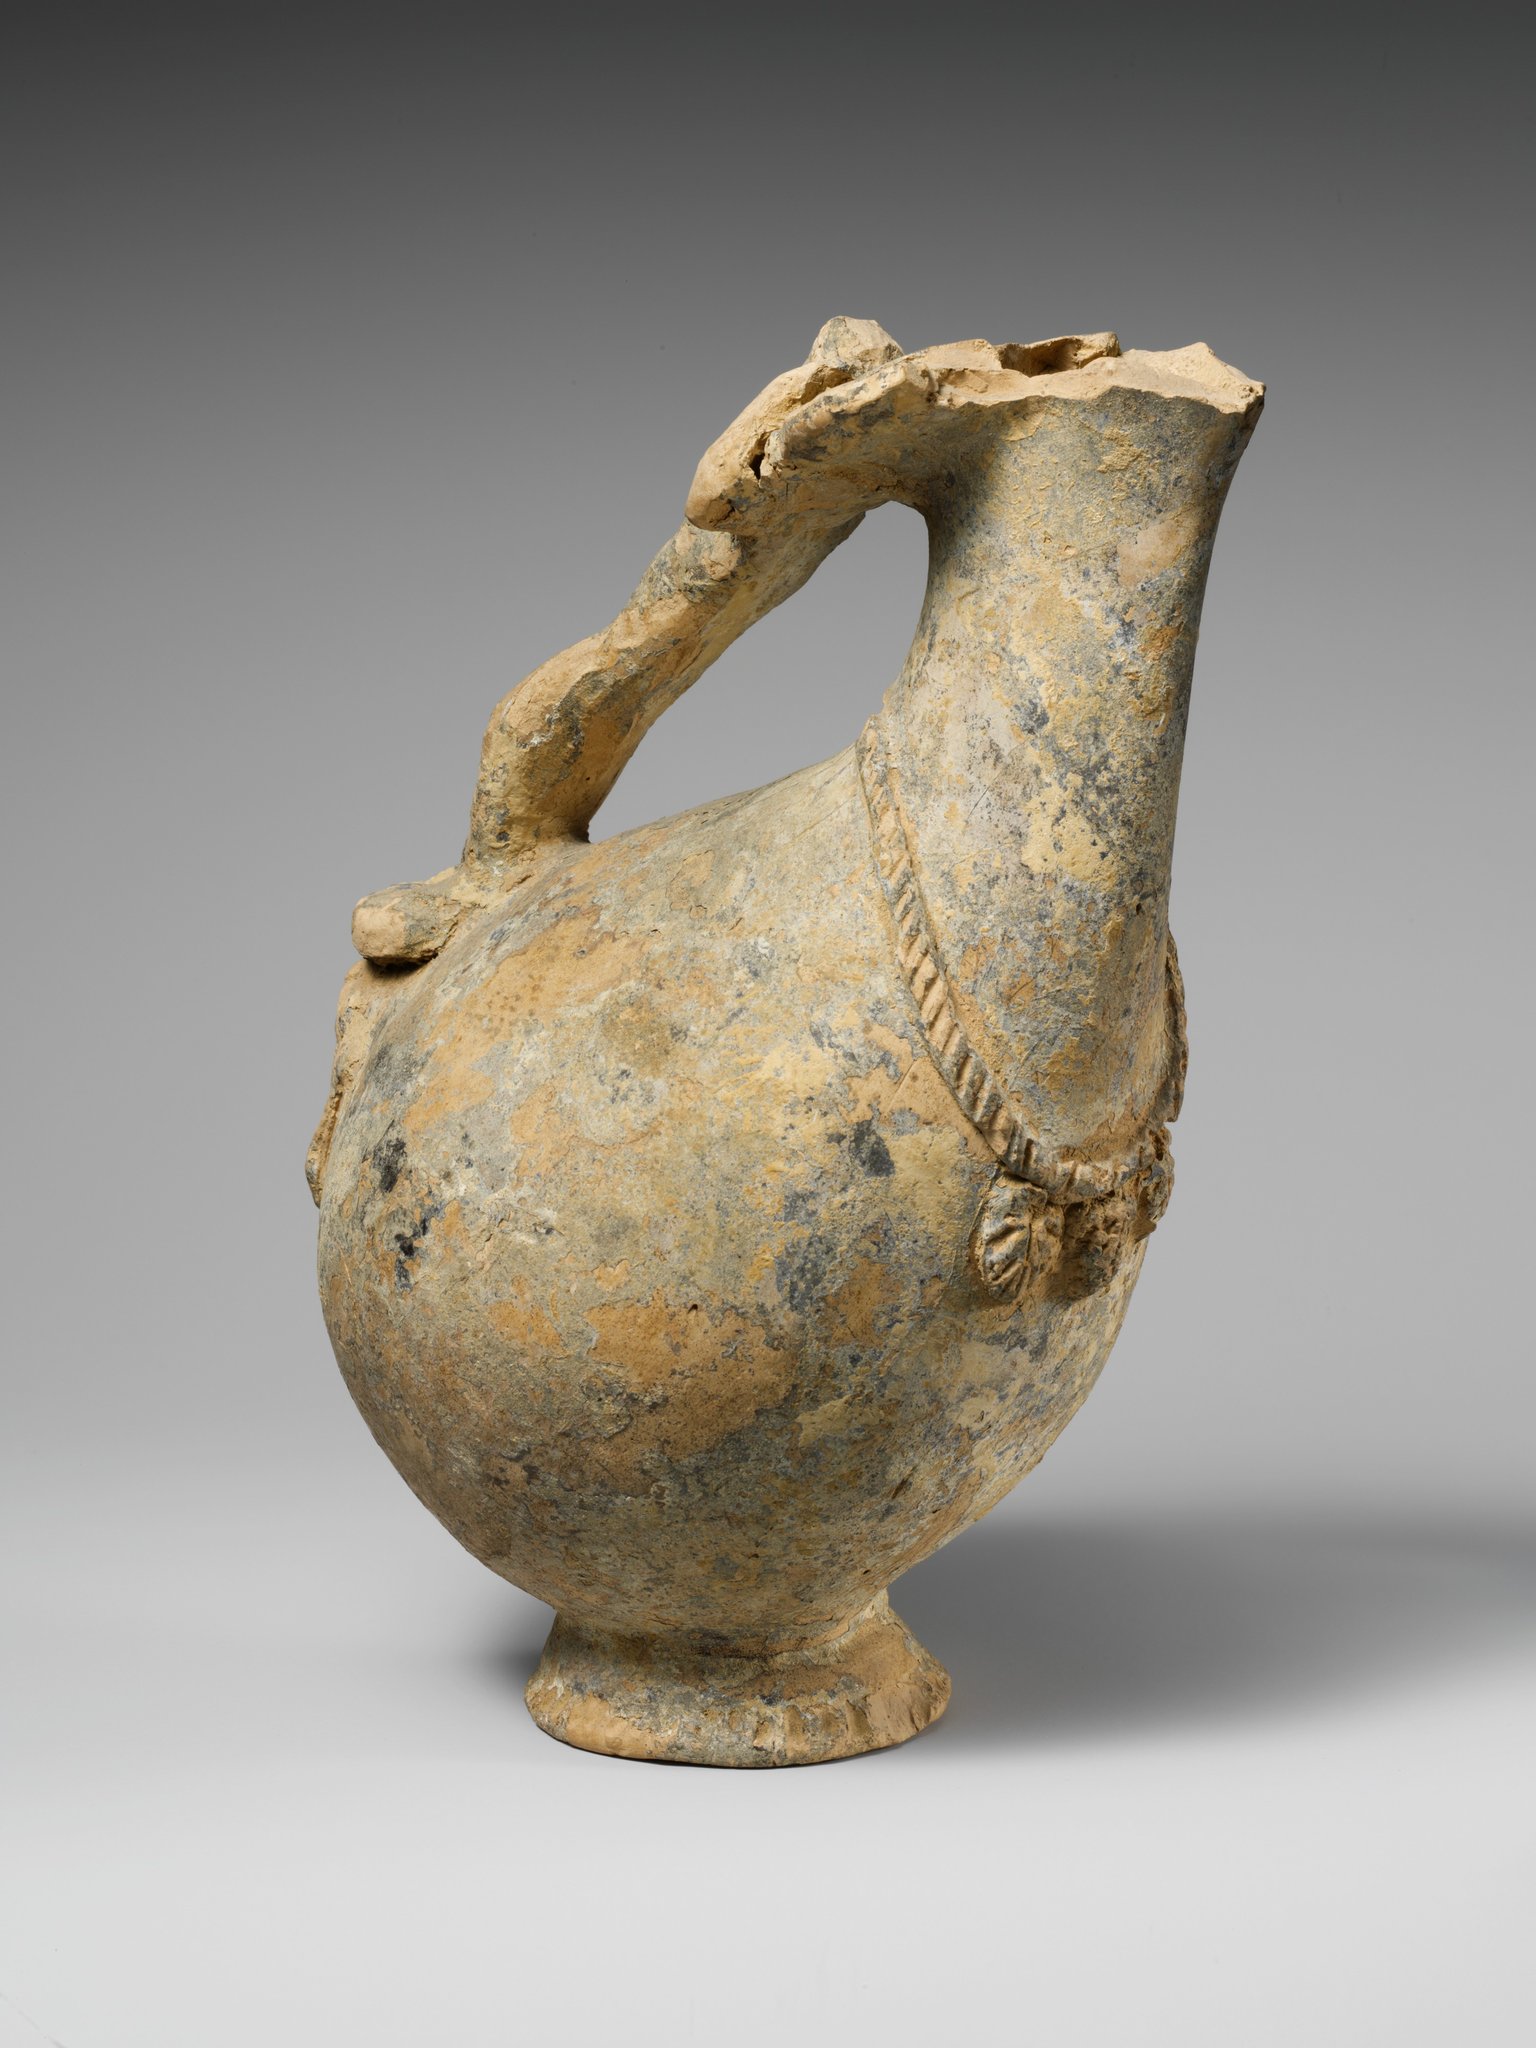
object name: askos, silvered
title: Terracotta askos (flask with a spout and handle over the top)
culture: etruscan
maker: bolsena group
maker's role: artist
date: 300-250 BCE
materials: terracotta